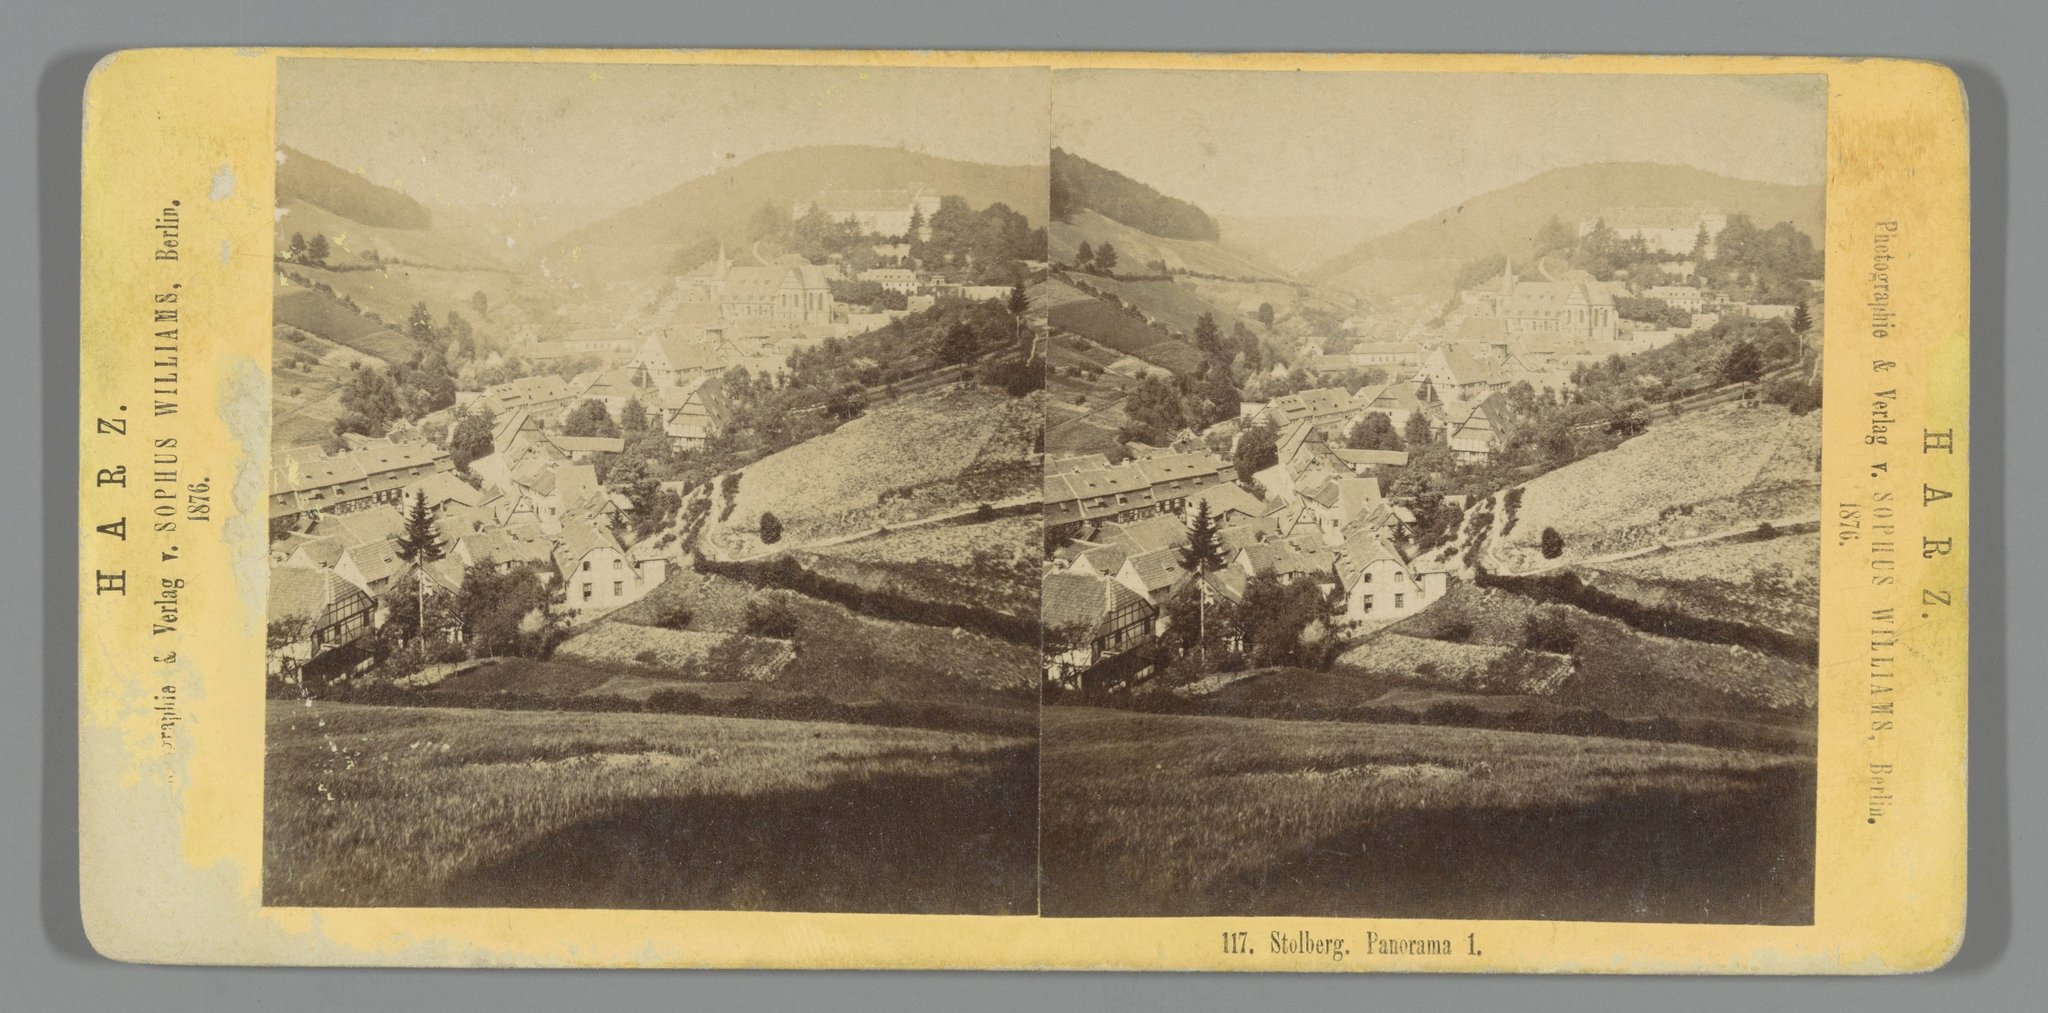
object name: stereograph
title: Gezicht op Stolberg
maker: sophus williams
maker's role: publisher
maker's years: 1835-1900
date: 1876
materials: cardboard, photographic support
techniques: albumen print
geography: harz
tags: stolberg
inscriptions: number: ‘117.’